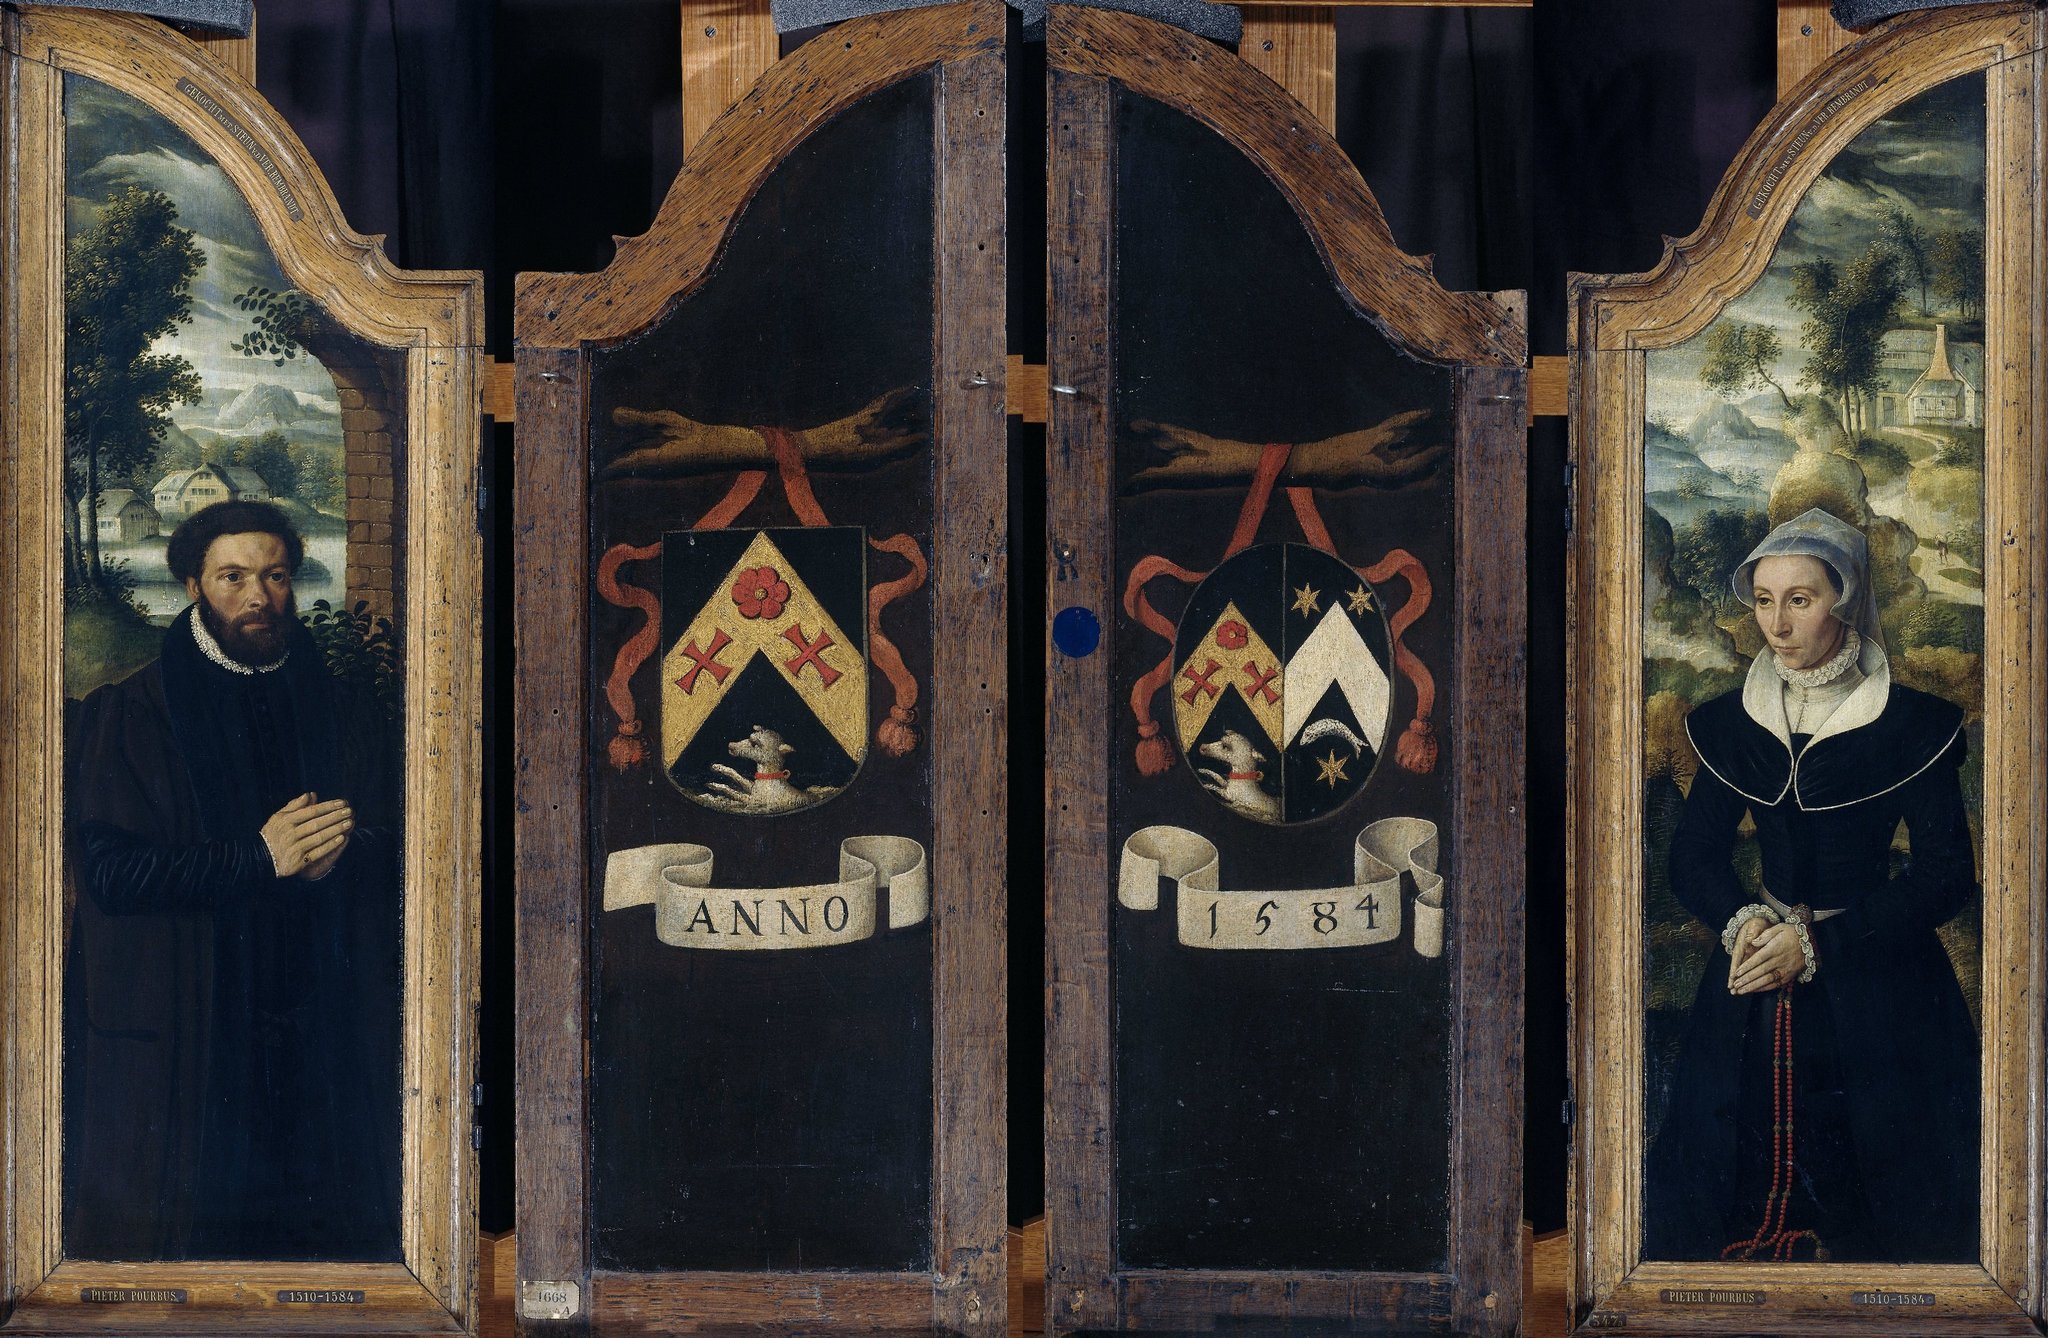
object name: triptych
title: Two Wings of a Triptych with the Portraits of Julien de Brouckere and his Wife Elisabeth Canneel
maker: Anonymous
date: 1584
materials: oil, panel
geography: bruges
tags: historical persons - bb - woman, historical persons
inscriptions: date: ‘Anno 1584’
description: Twee vleugels van een drieluik. Aan de binnenzijde van het linkerzijpaneel het portret van Julien de Brouckere, knielend in aanbidding in een landschap. Rechts zijn vrouw Elisabeth Canneel, eveneens knielend in aanbidding in een landschap. Op de buitenzijden van de zijpanelen staan de familiewapens van de geportretteerden.